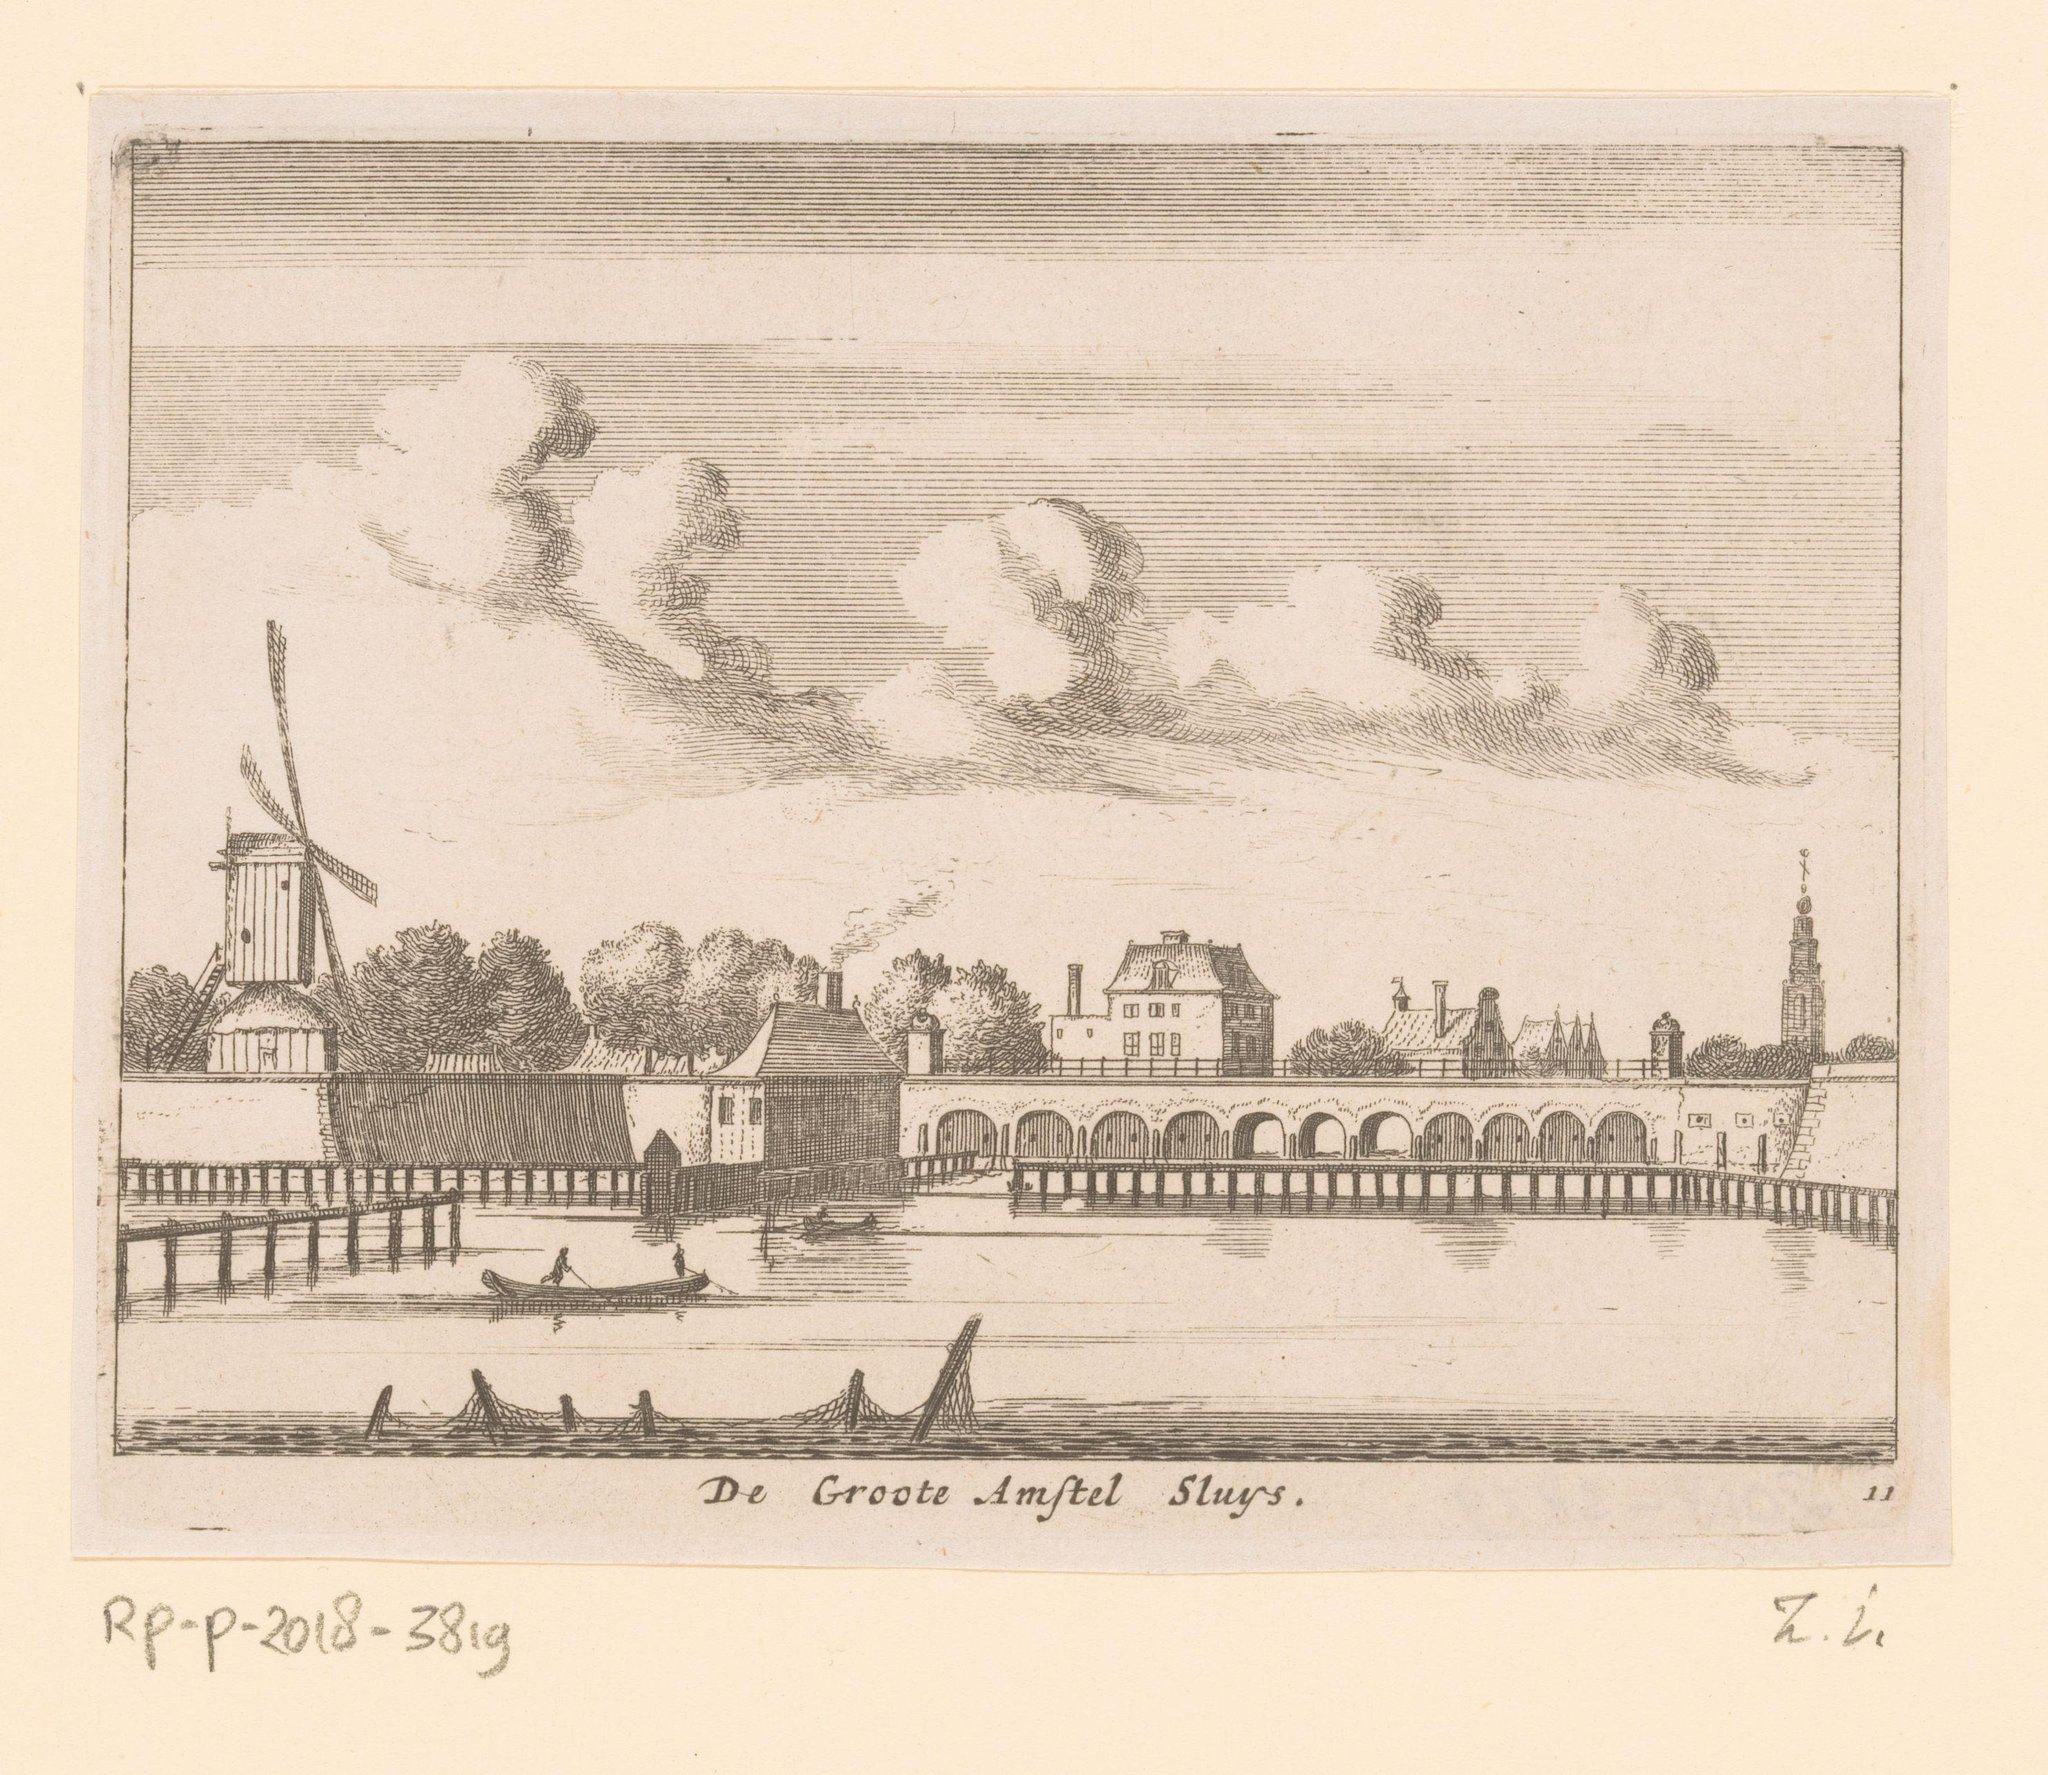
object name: print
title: De Groote Amstel Sluys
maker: Anonymous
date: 1700-1730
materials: paper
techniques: etching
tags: canals, waters (in city), bridge in city across river, canal, etc., windmill